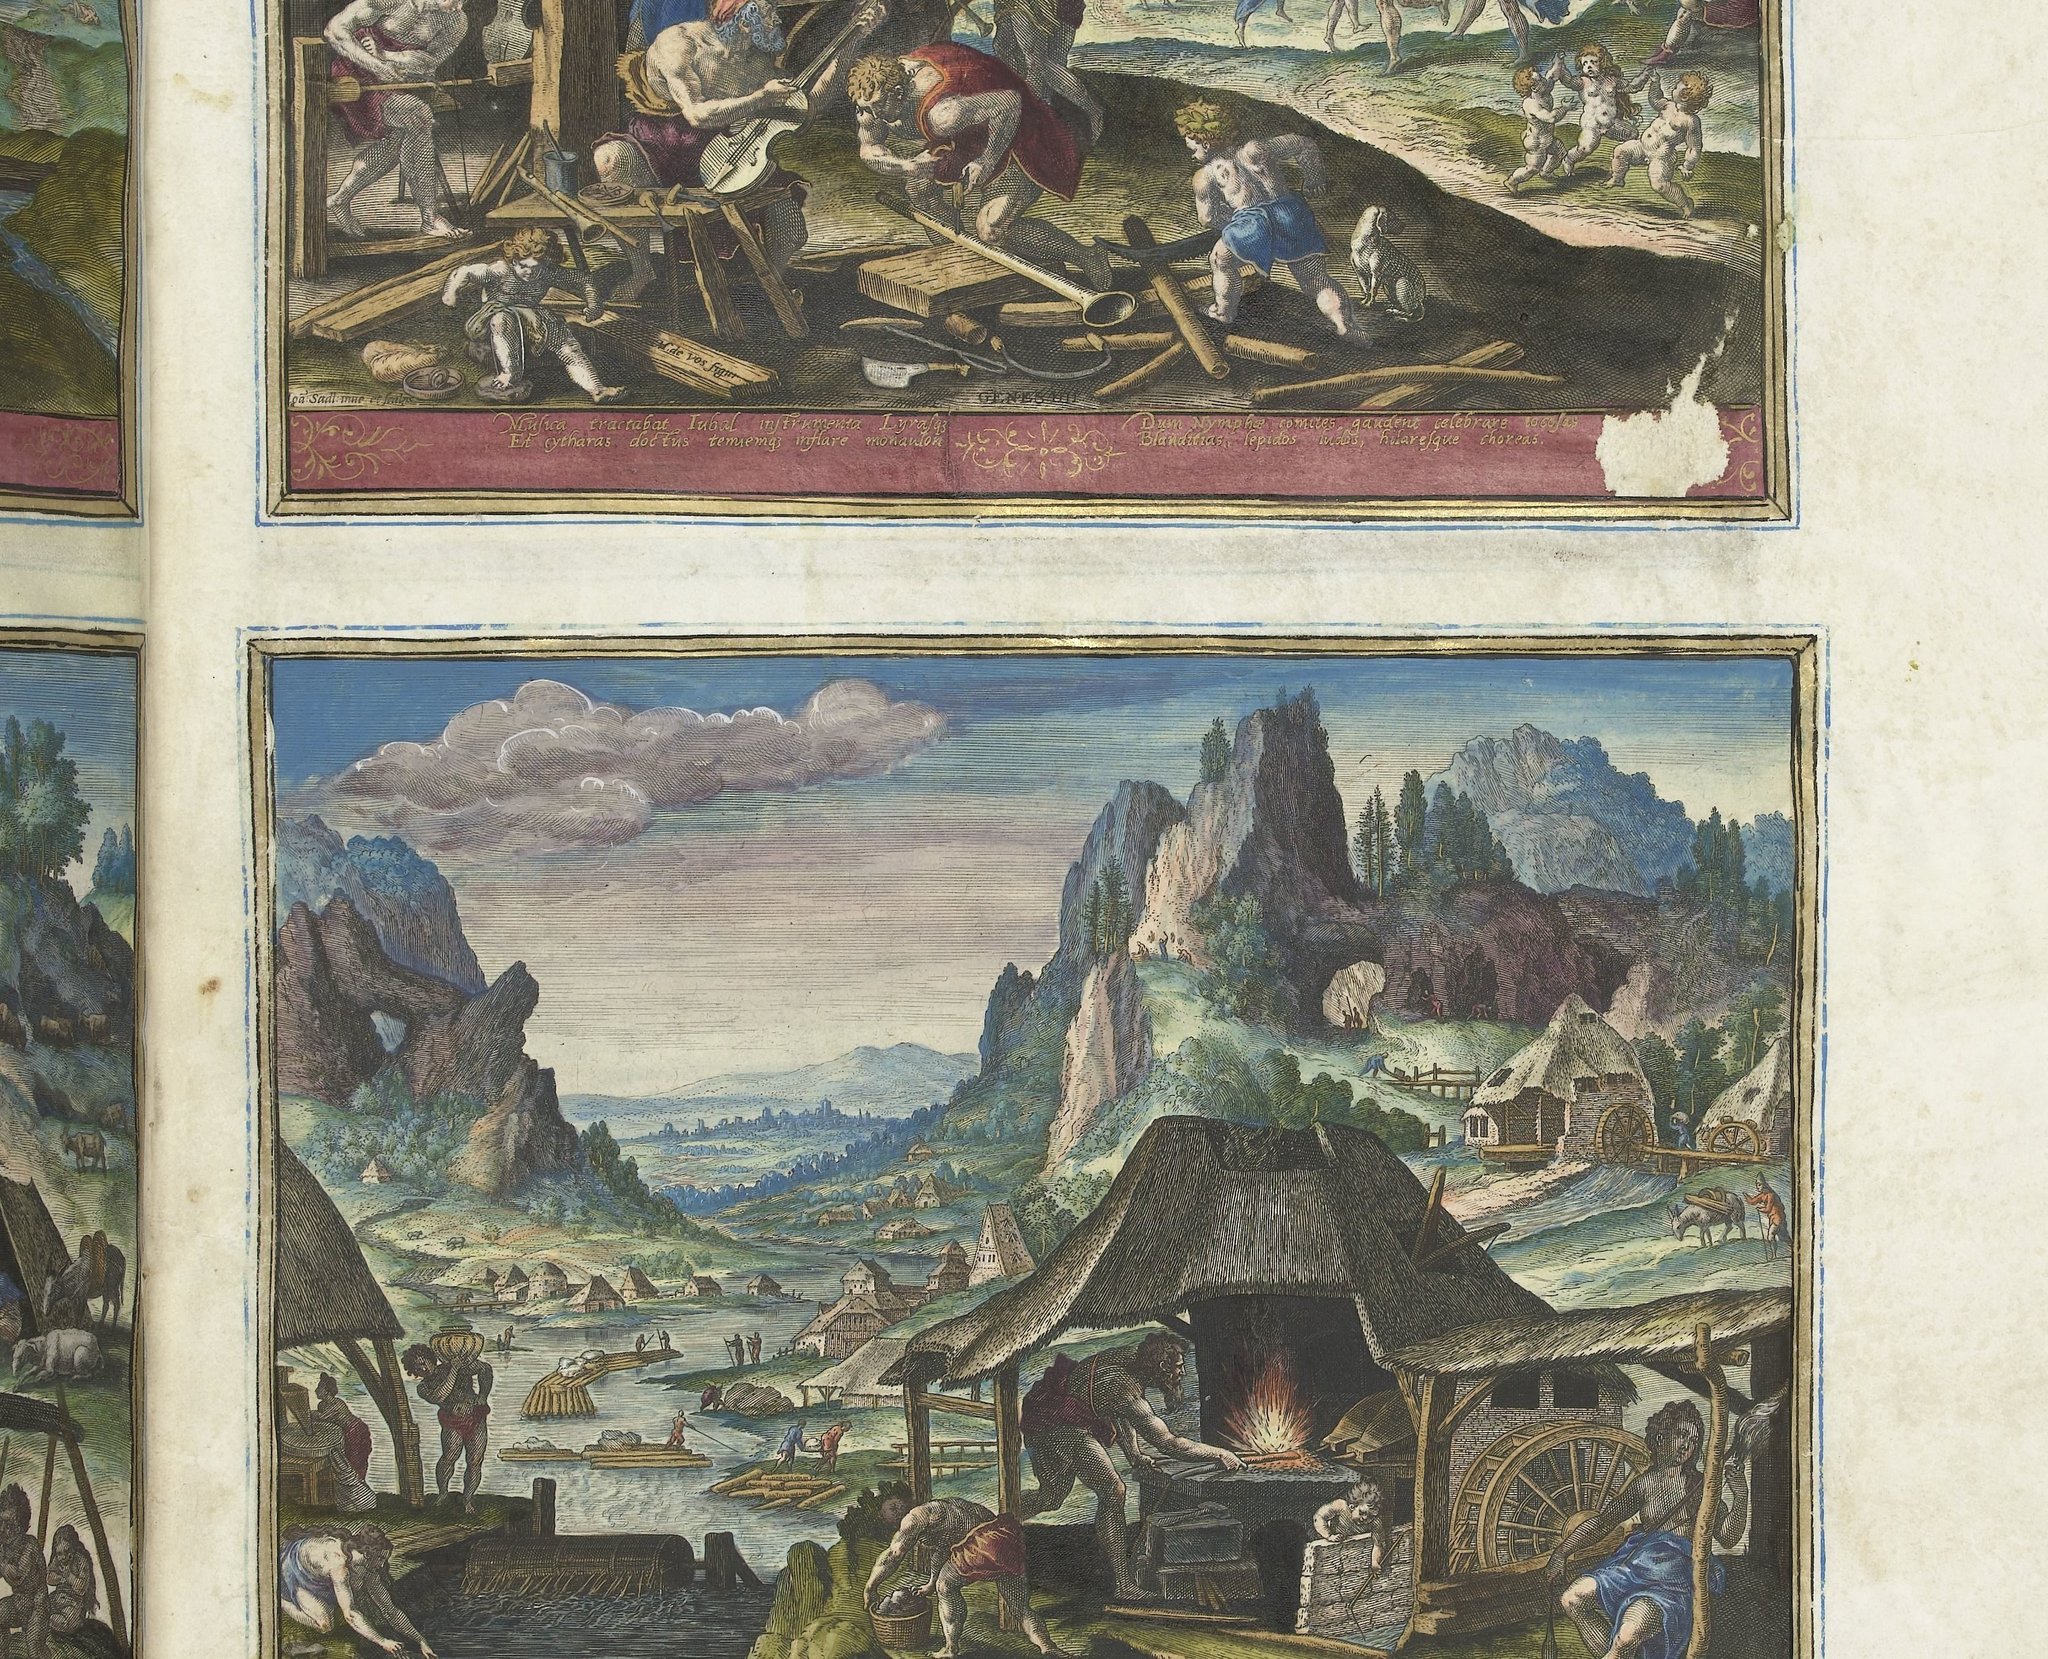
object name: album leaf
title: Boni et mali scientia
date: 1583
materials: paper, parchment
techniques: engraving, hand coloring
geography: antwerp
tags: story of tubalcain, the first blacksmith, smith, blacksmith, spinning (manufacture of yarn)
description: Tubal-Kaïn, de stamvader van allen die brons en ijzer bewerken, in zijn smidse. Rechts zijn zus Naäma die garen spint. Onder de voorstelling een verklarende tekst in het Latijn. Deze prent maakt deel uit van een album.